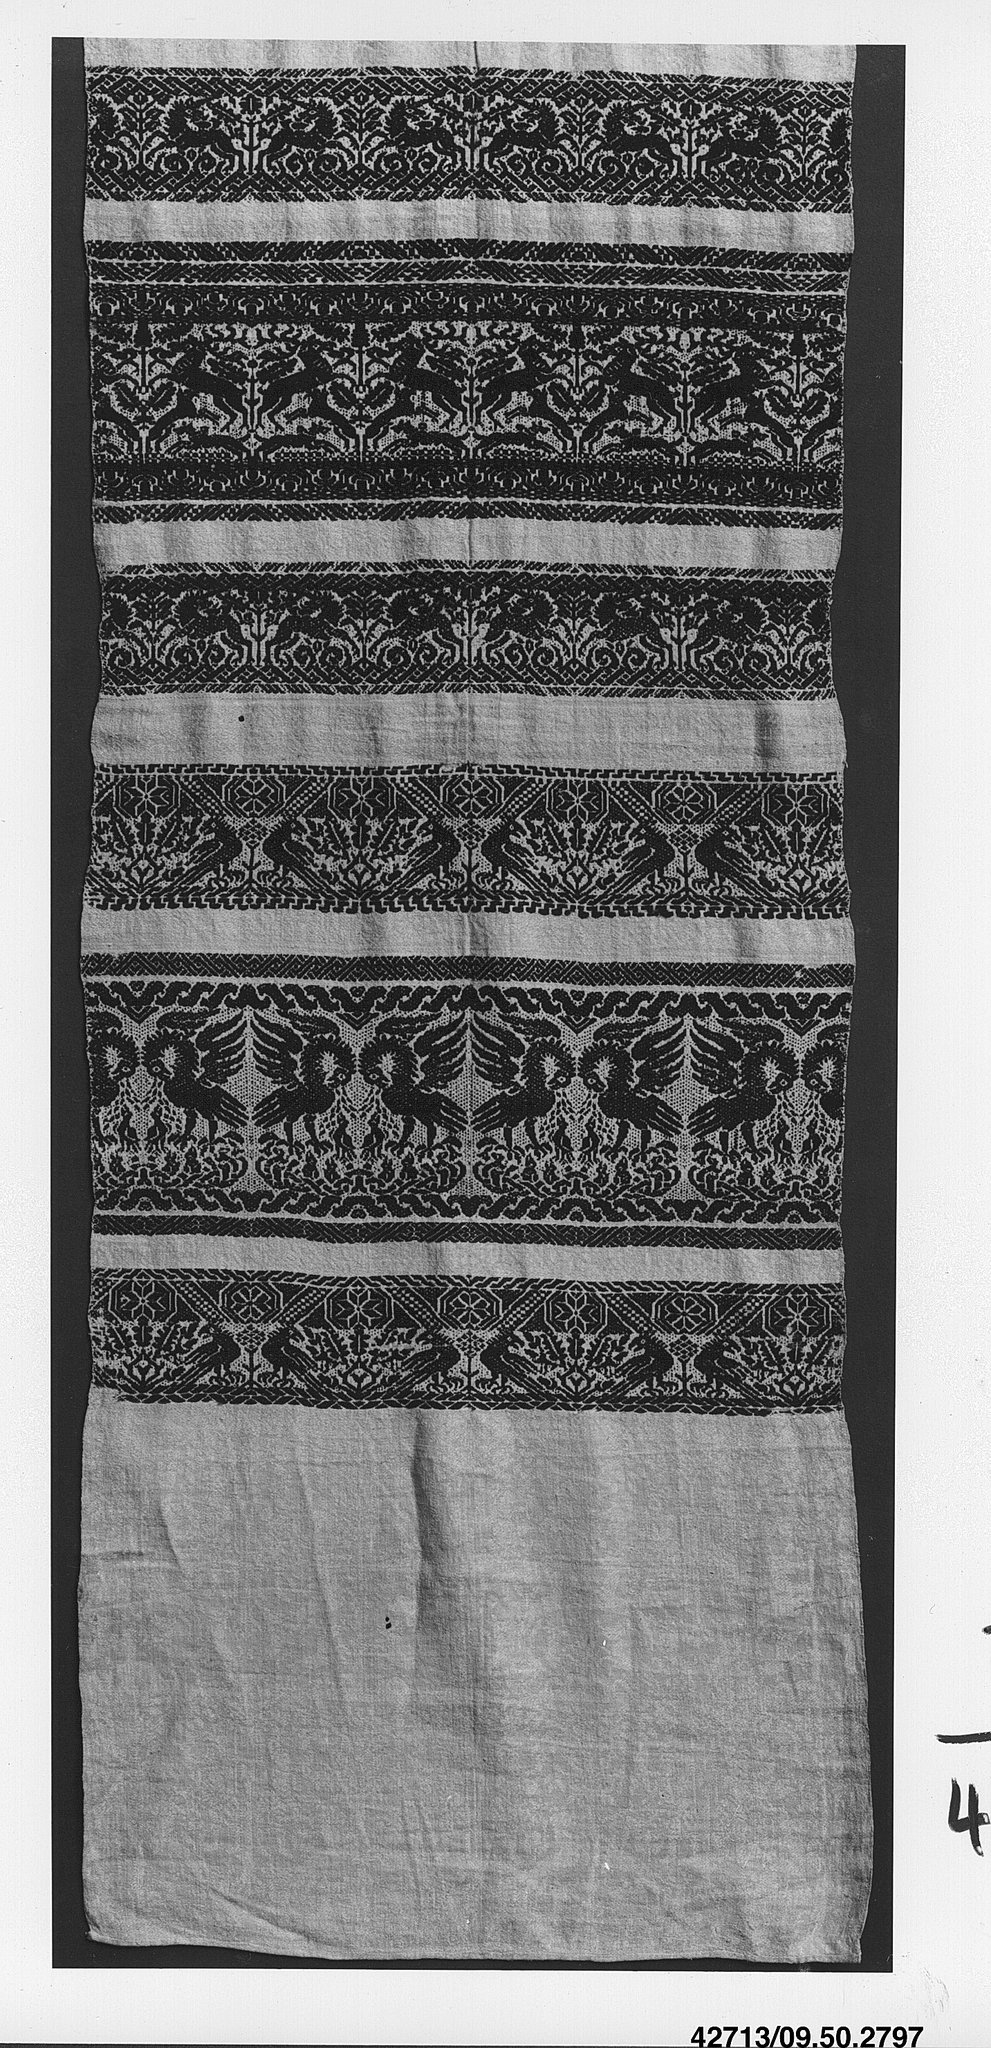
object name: piece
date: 1501-1700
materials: linen, wool